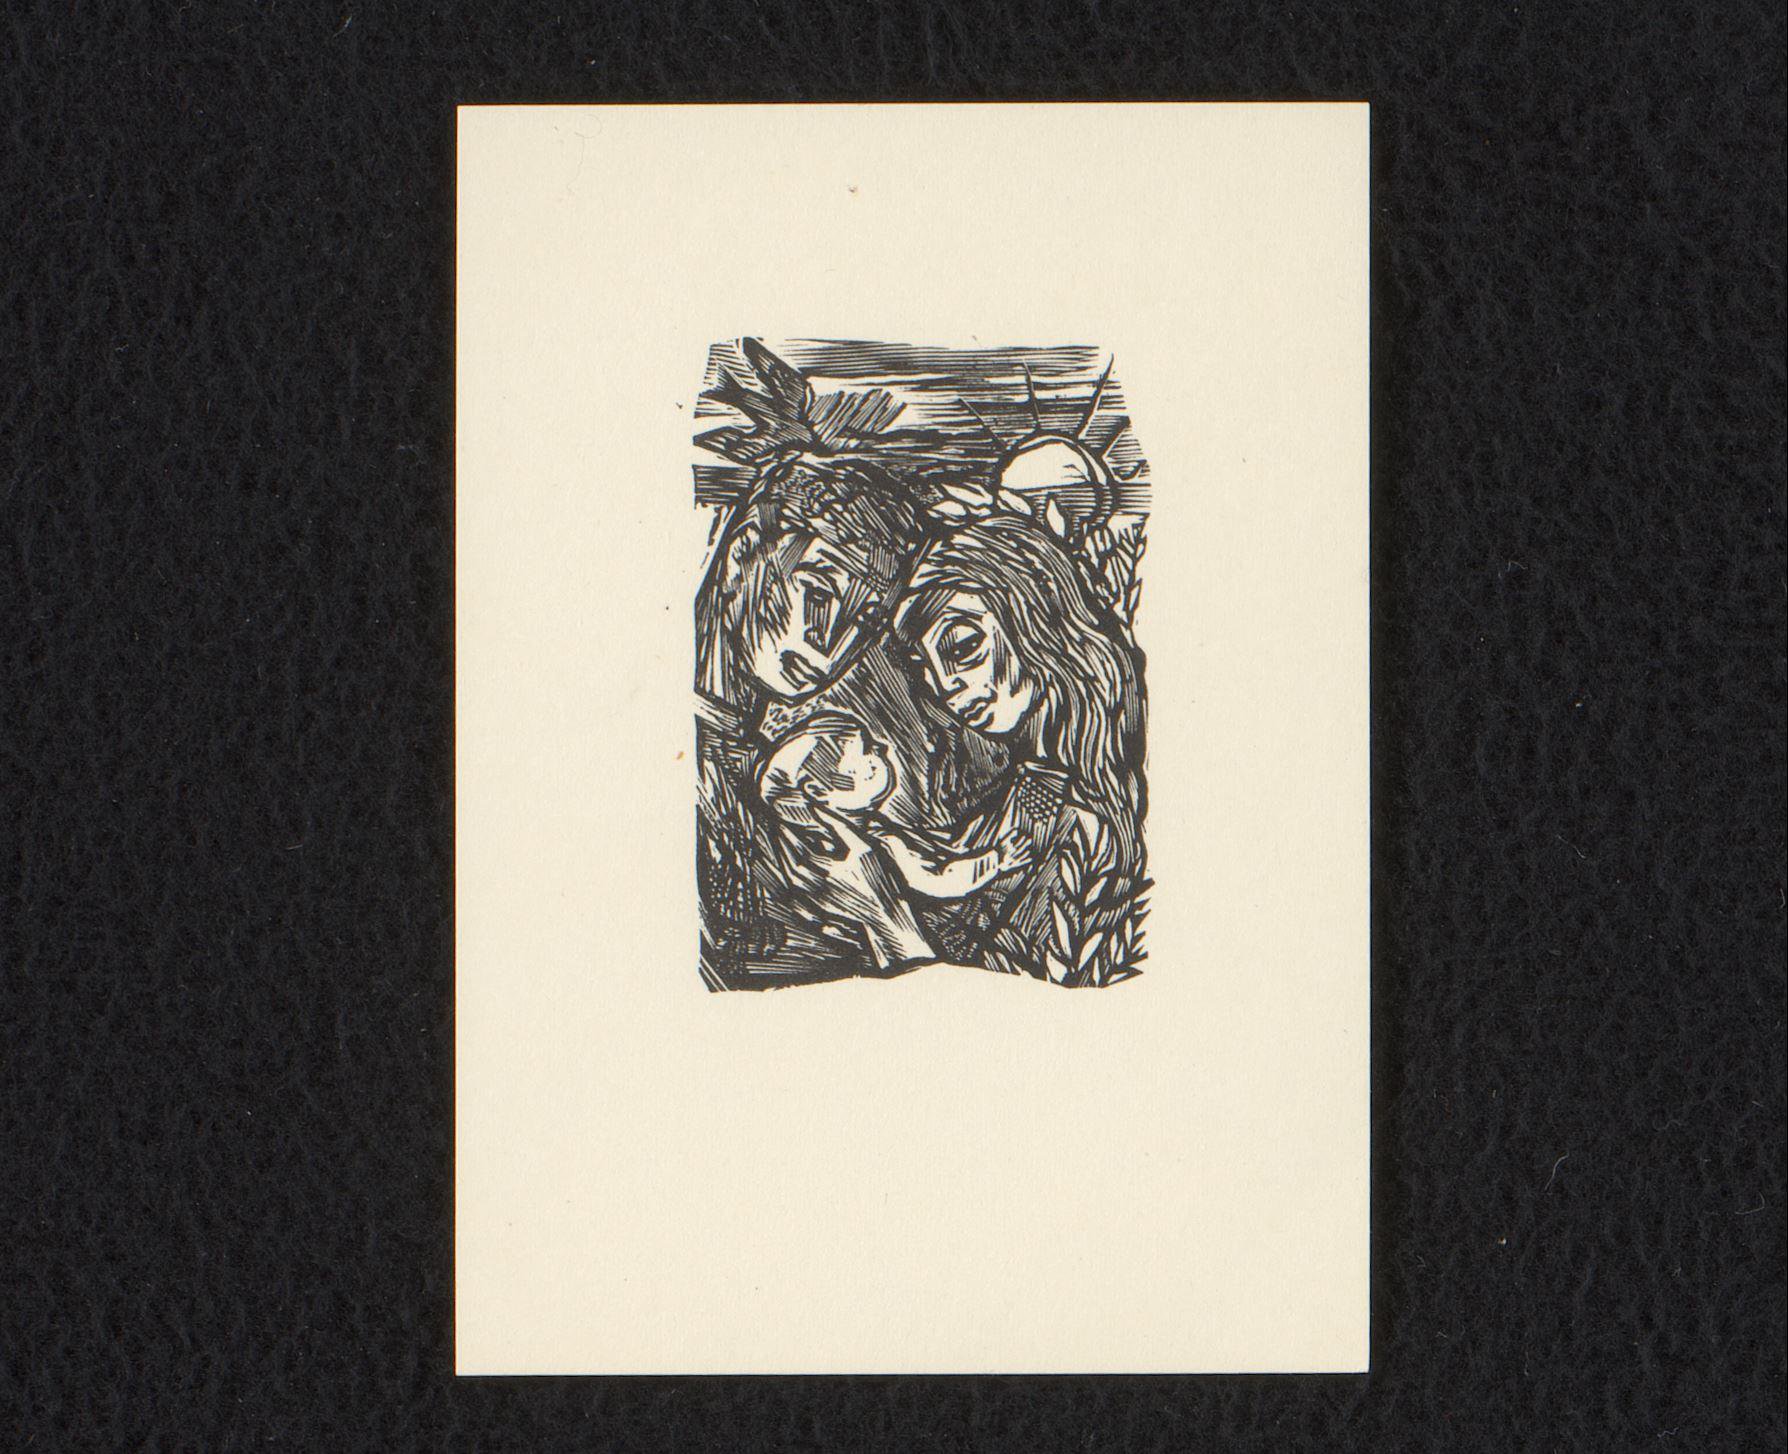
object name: print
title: Maria met Christus en Jozef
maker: Anonymous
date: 1930-1980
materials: paper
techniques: engraving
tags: mary, joseph and the new-born christ (nativity)